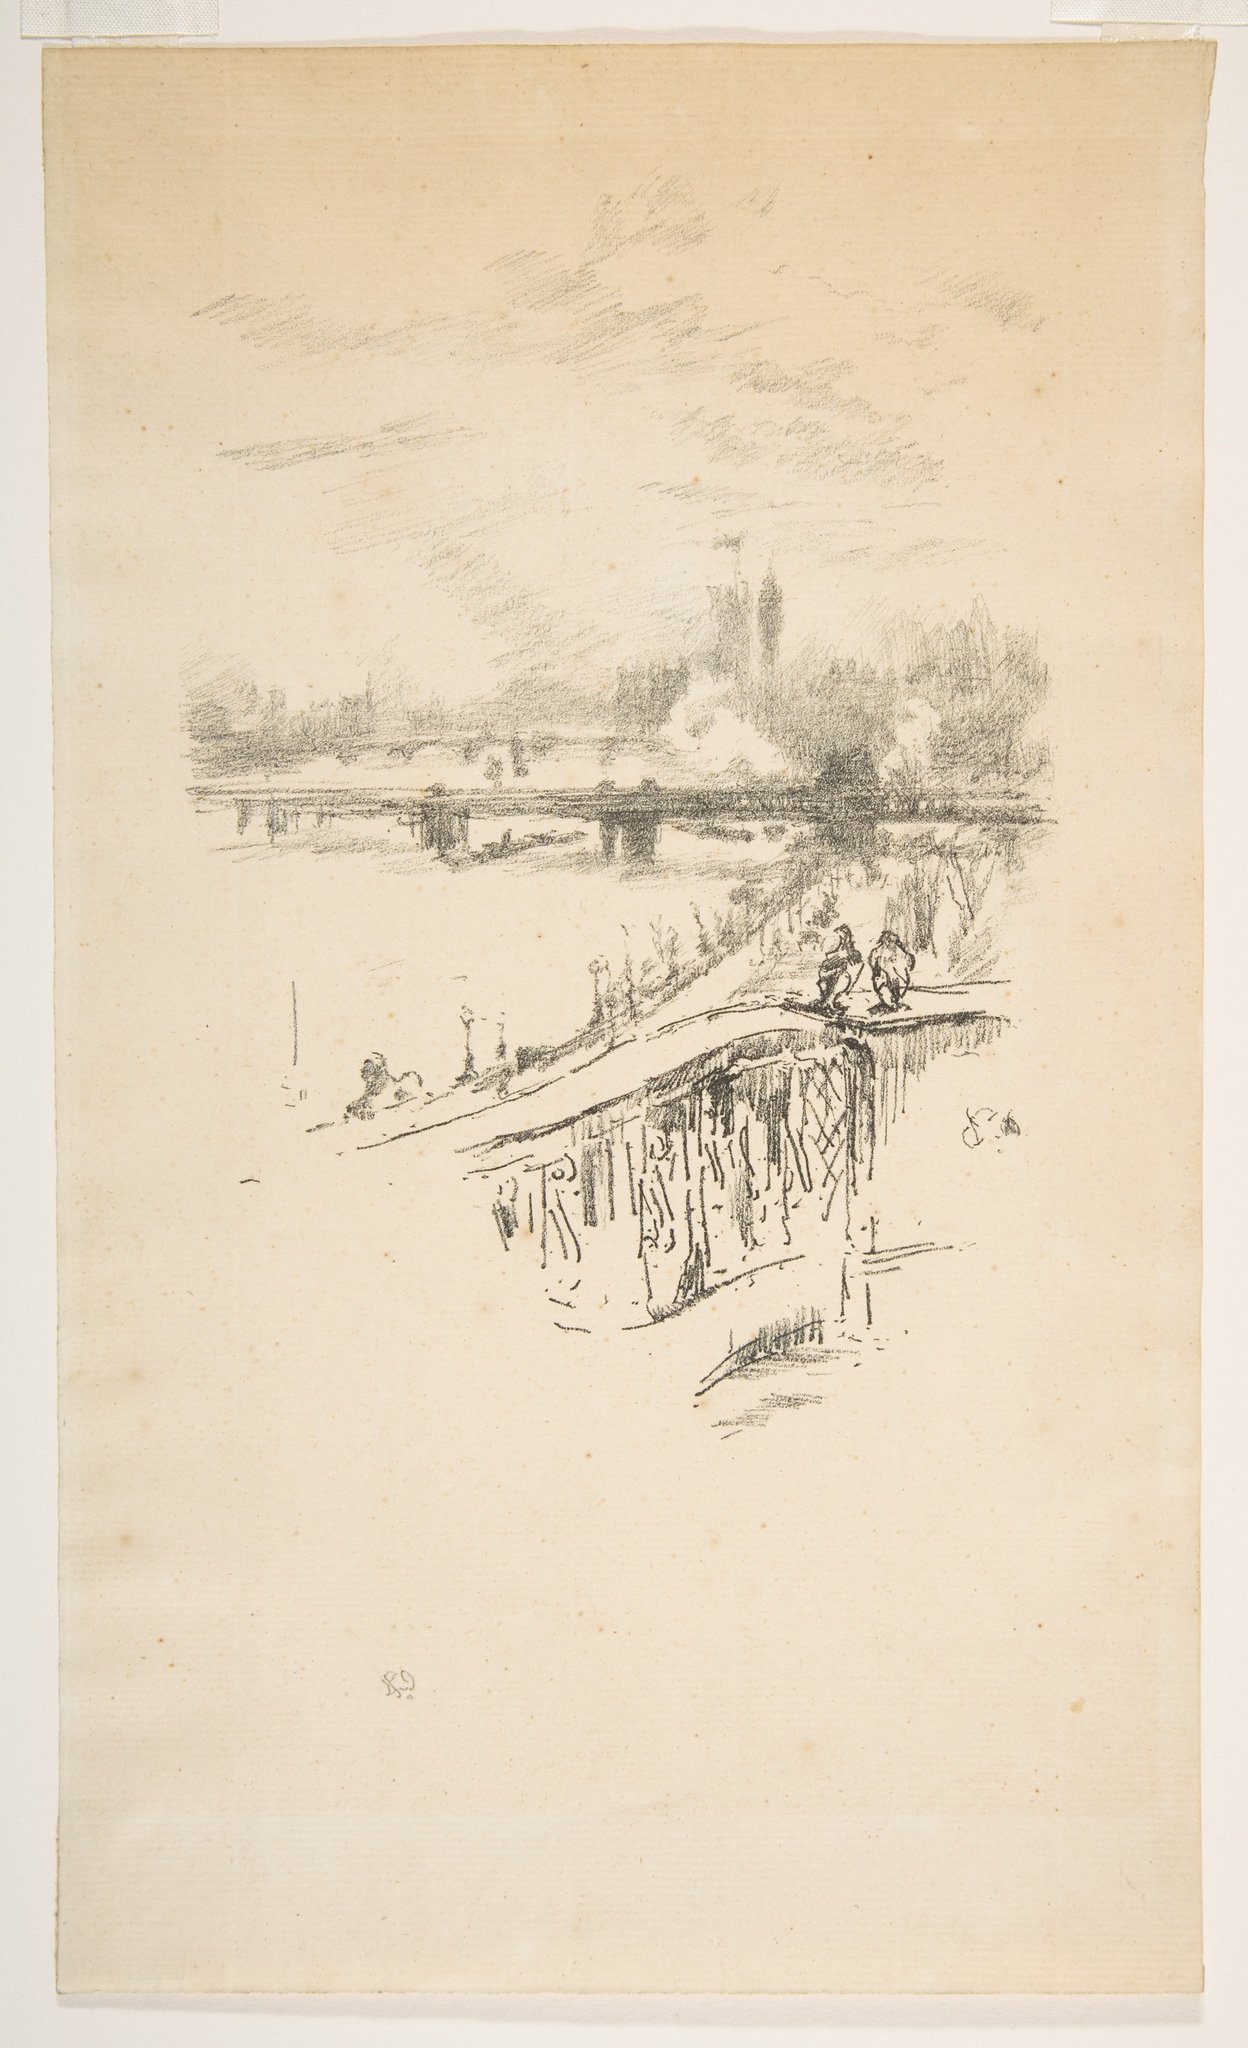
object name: print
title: Savoy Pigeons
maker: james mcneill whistler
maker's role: artist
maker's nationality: american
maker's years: 1834-1903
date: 1896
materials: ink, paper, stone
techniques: printing, lithography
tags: bridges,pigeons